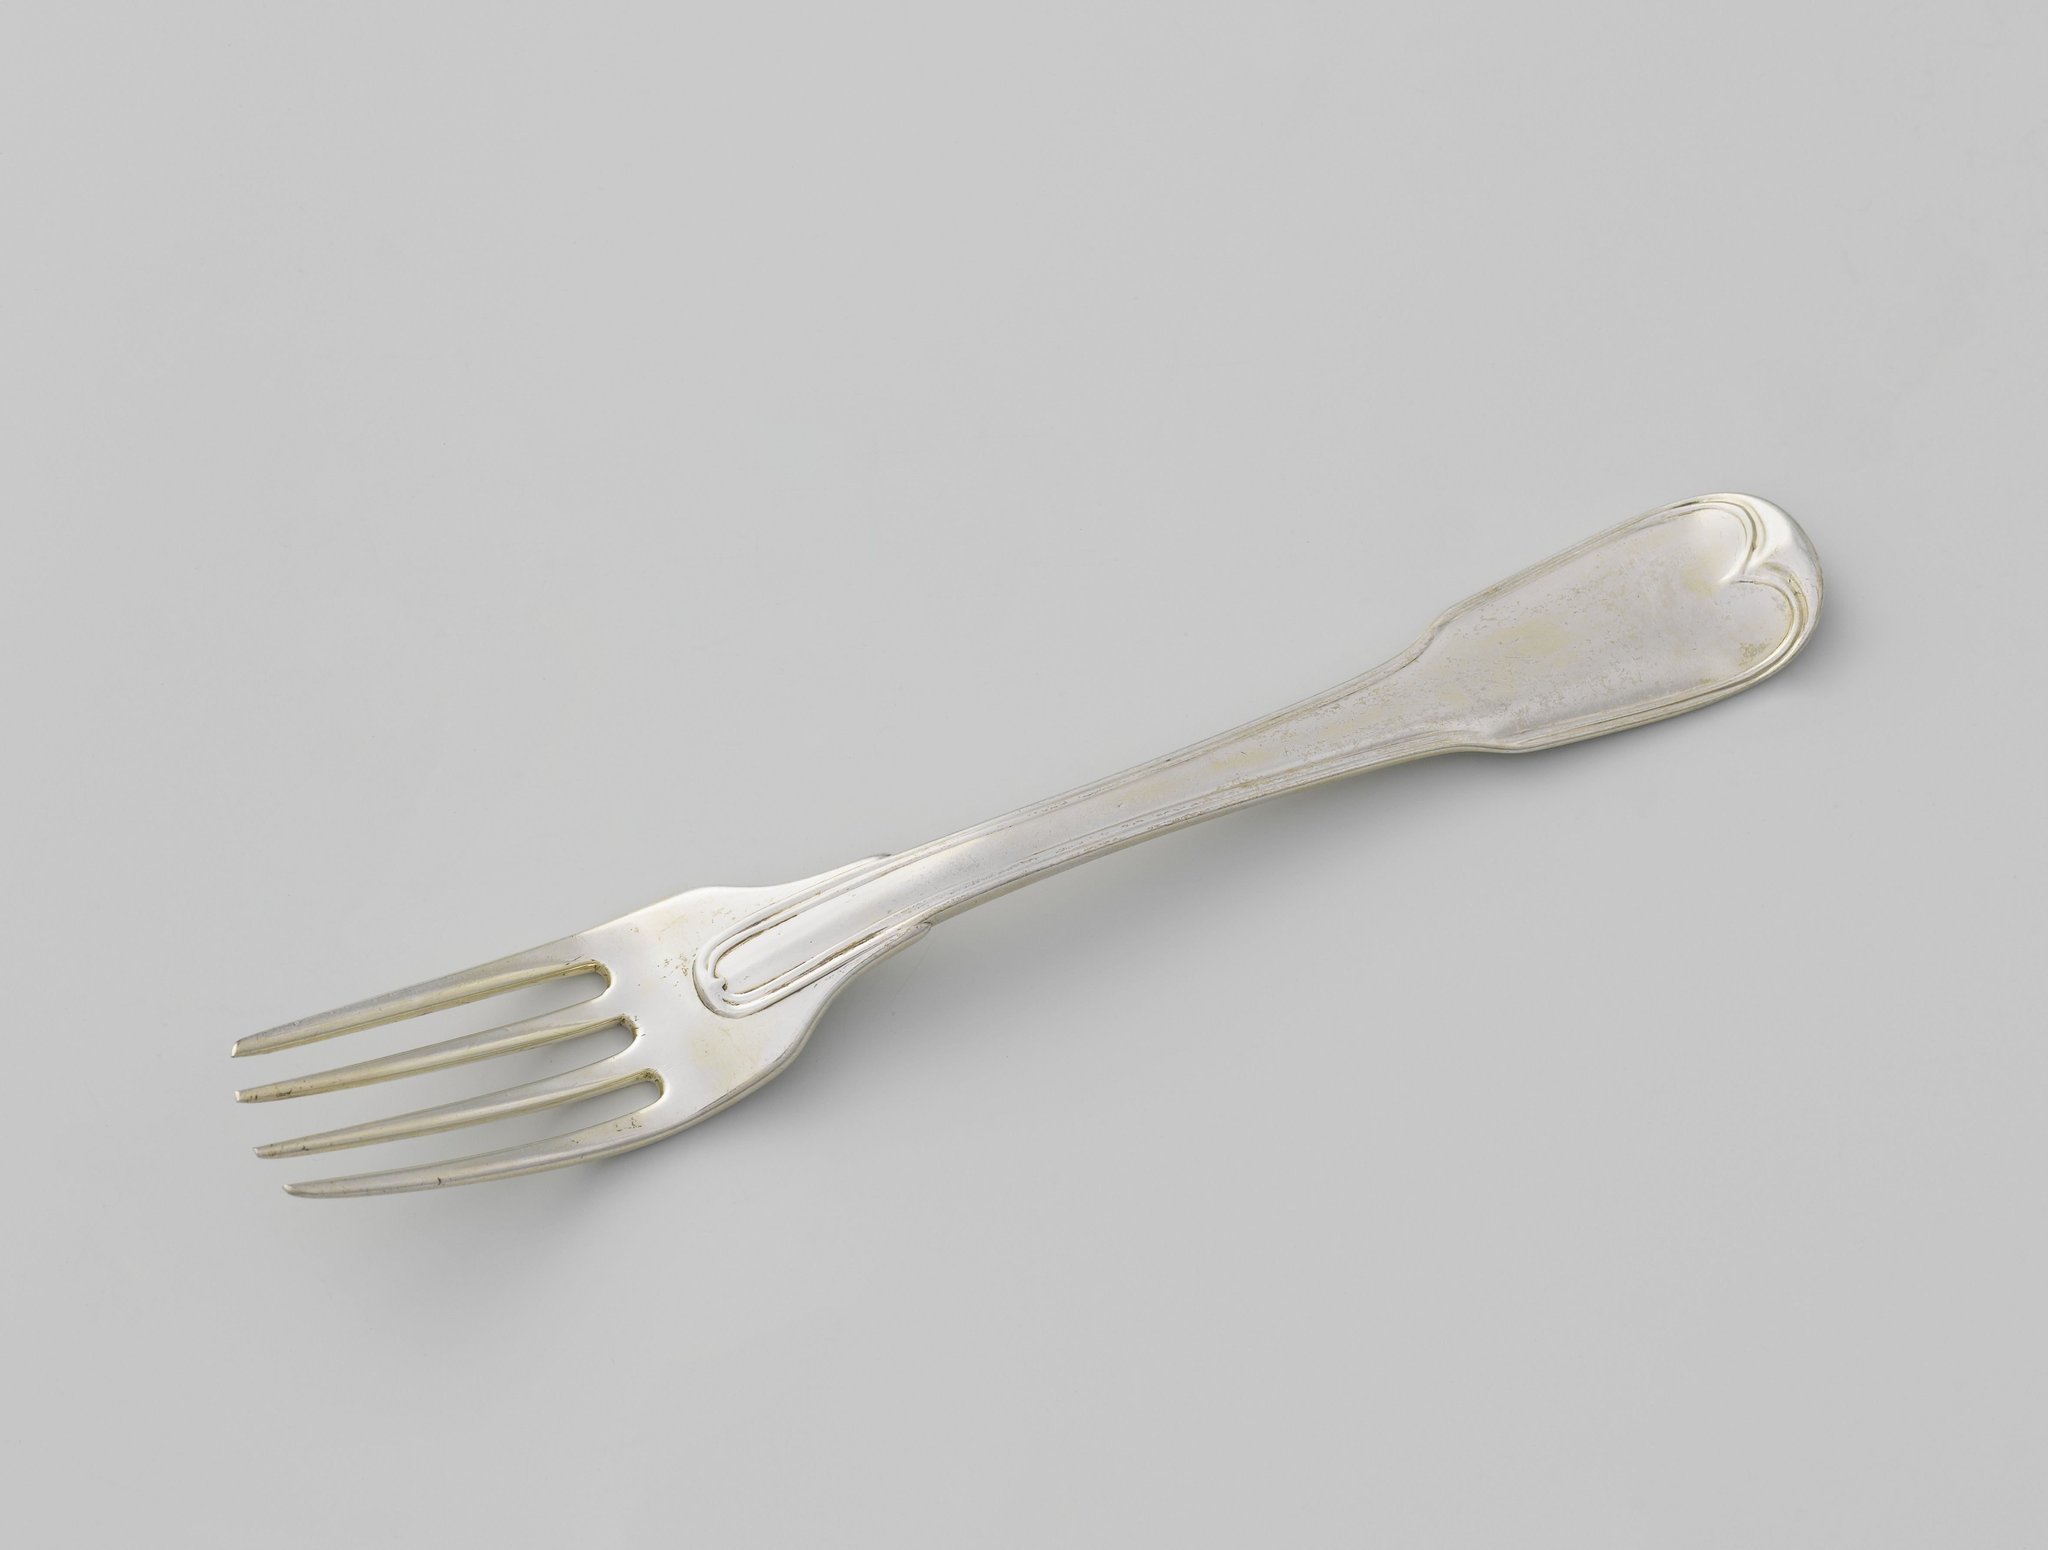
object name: fork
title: Vork met het helmteken Clifford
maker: roelof helweg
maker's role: silversmith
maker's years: 1758-1843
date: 1806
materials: silver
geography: amsterdam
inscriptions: date letter: ‘X (=1806)’, town mark: ‘Amsterdam’, maker's mark: ‘RH in ovaal’, alloy mark: ‘Hollandse leeuw’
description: De viertandige vork is aan zowel boven- als onderzijde door middel van enkel lof verbonden met de platte, gebogen steel, die zich verbreedt naar het spatelvormige uiteinde. Boven- en onderzijde van de steel worden omgeven door een dubbele filetrand, die bij het uiteinde ingezwenkt is. Op de onderzijde van de spatel is het helmteken Clifford gegraveerd.